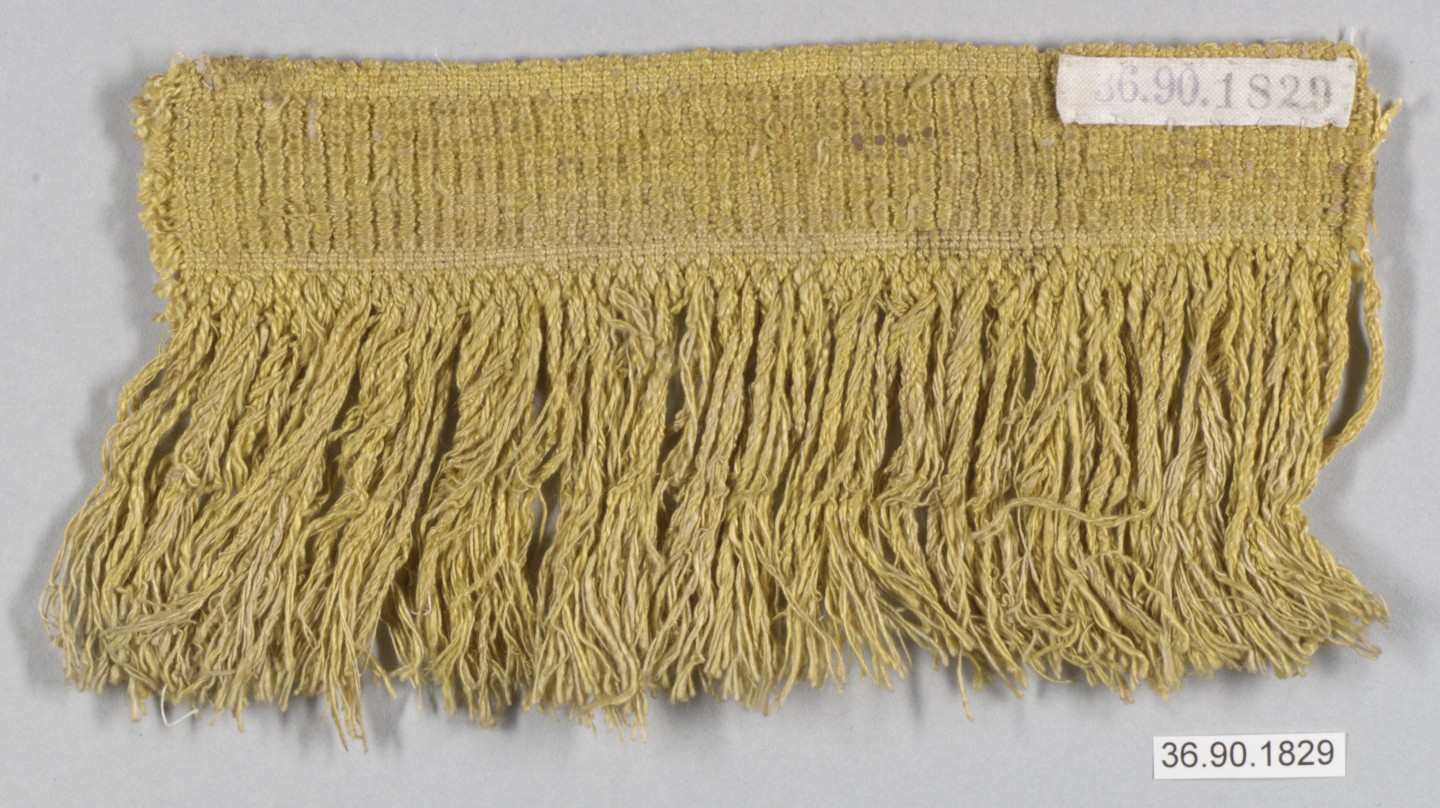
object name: fringe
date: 1701-1733